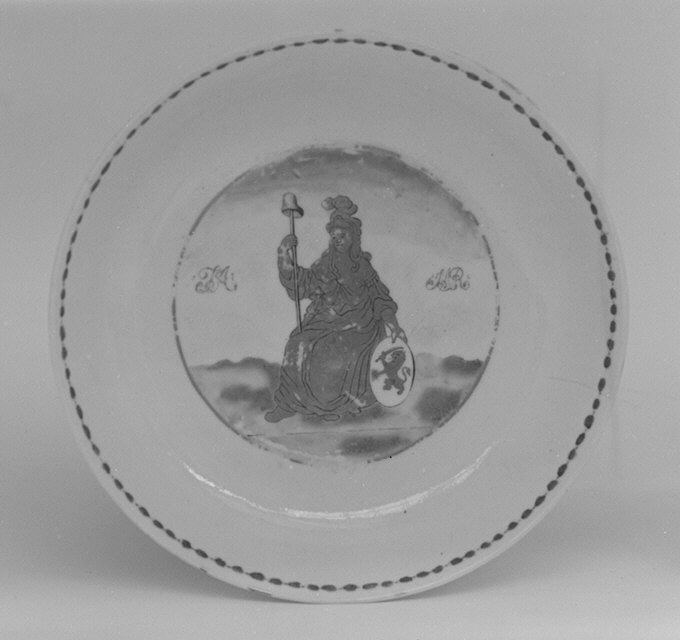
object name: saucer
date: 1795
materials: hard paste porcelain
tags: women,coat of arms